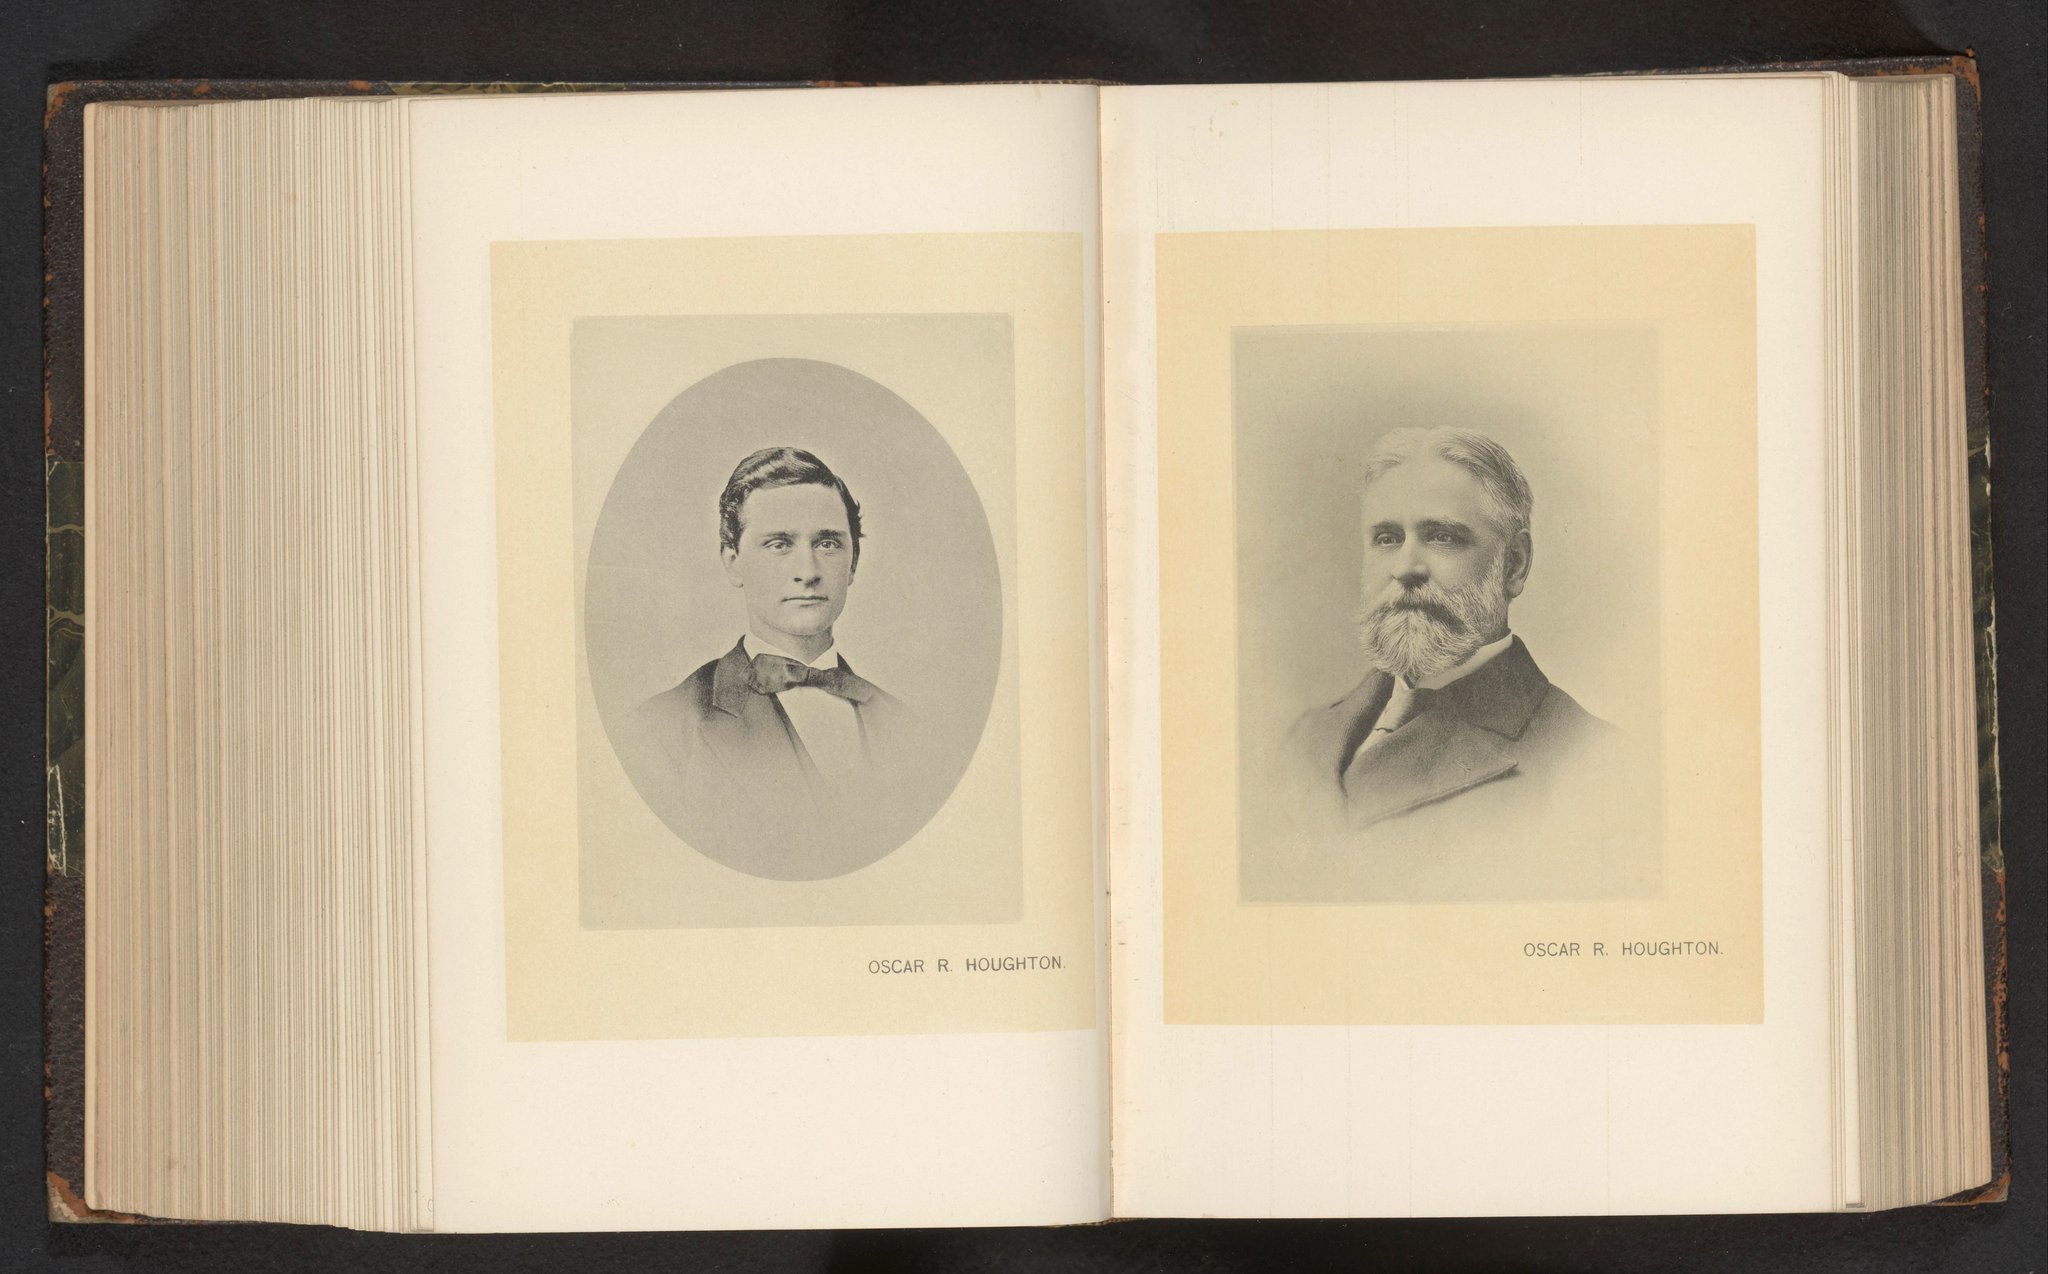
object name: photomechanical print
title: Oscar R. Houghton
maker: Anonymous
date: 1869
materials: paper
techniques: photoaquatint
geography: boston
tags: adult man